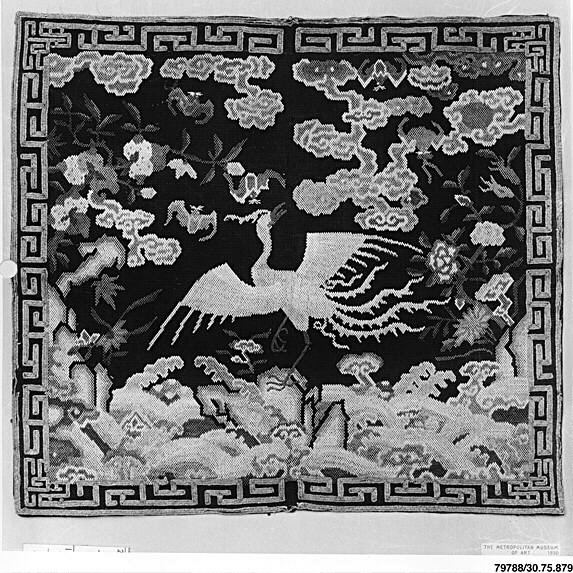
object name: rank badge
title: Rank Badge with Silver Pheasant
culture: chinese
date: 1734-1766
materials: metal thread, silk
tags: bats,pheasants